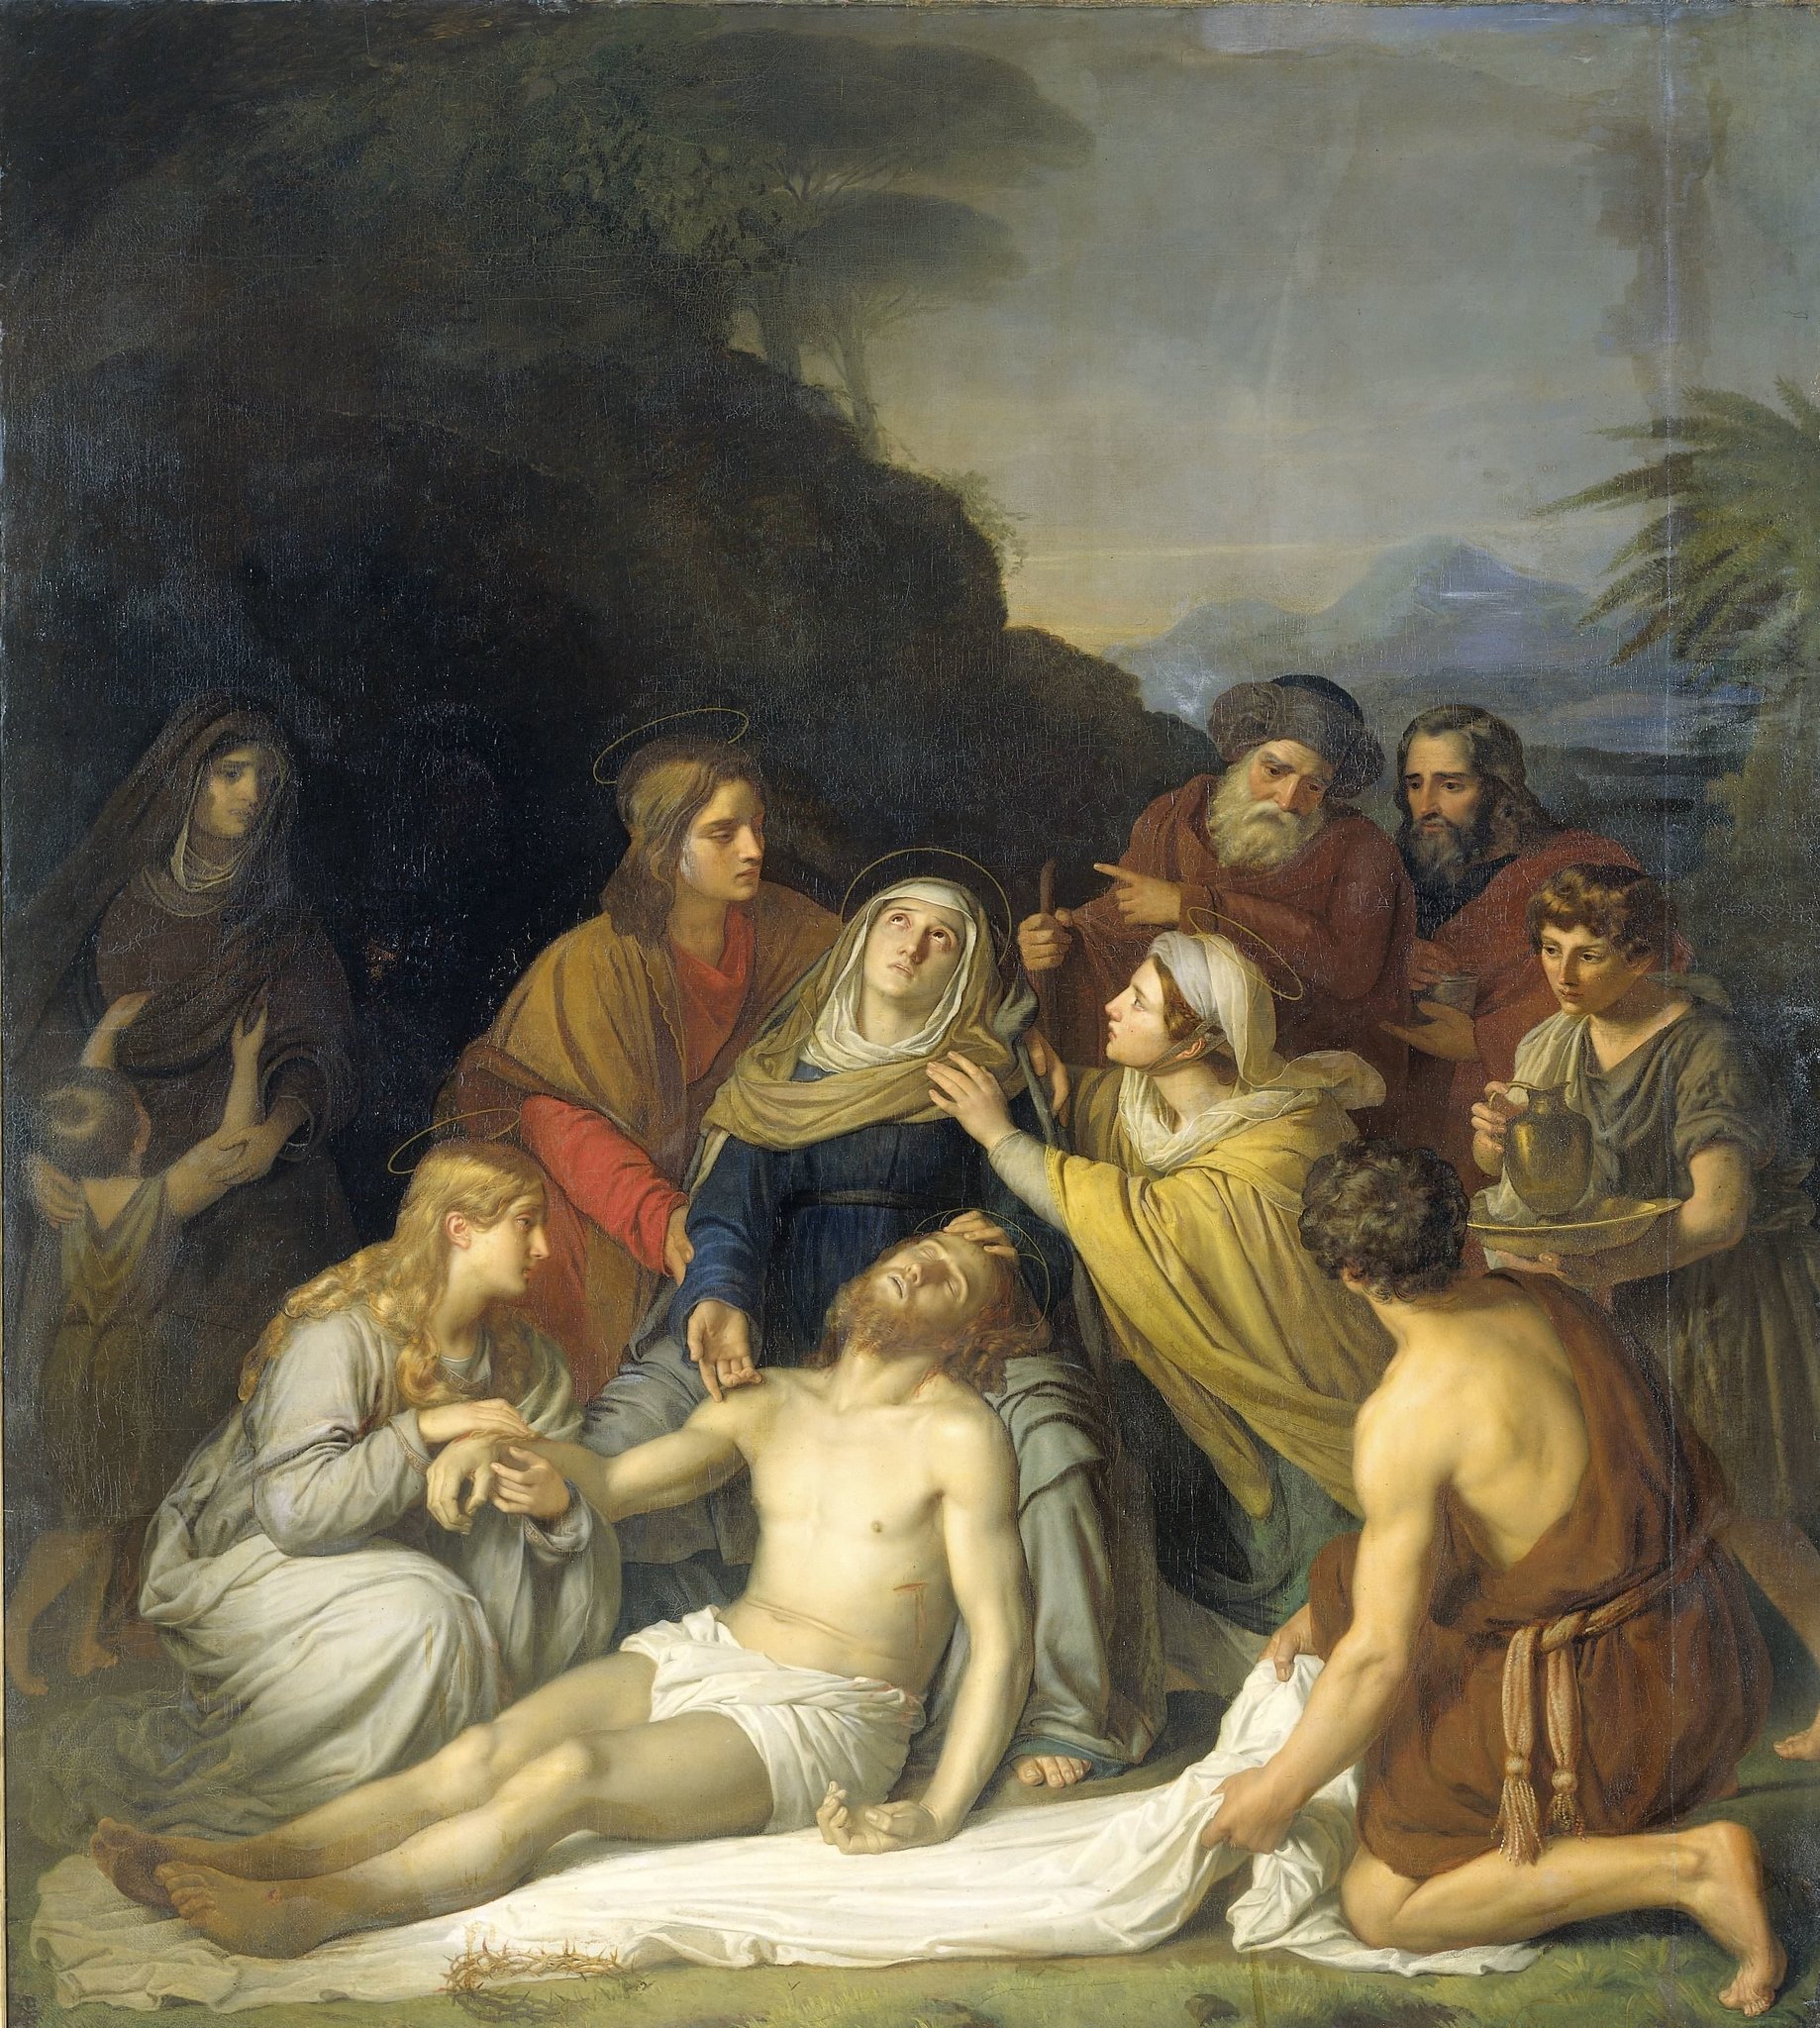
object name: painting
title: The Entombment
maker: cornelis kruseman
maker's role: draughtsman, painter, print maker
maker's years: 1797-1857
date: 1830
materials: canvas, oil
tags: christ's body is wrapped in a shroud and in bandages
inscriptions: signature and date: ‘C. Kruseman f. Hagae 1830’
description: De graflegging van Christus. Maria steunt het lichaam van Christus in haar schoot, links Johannes en Maria Magdalena. Rechts Jozef van Arimathea en Nicodemus en een jongen met een kan op een schaal.